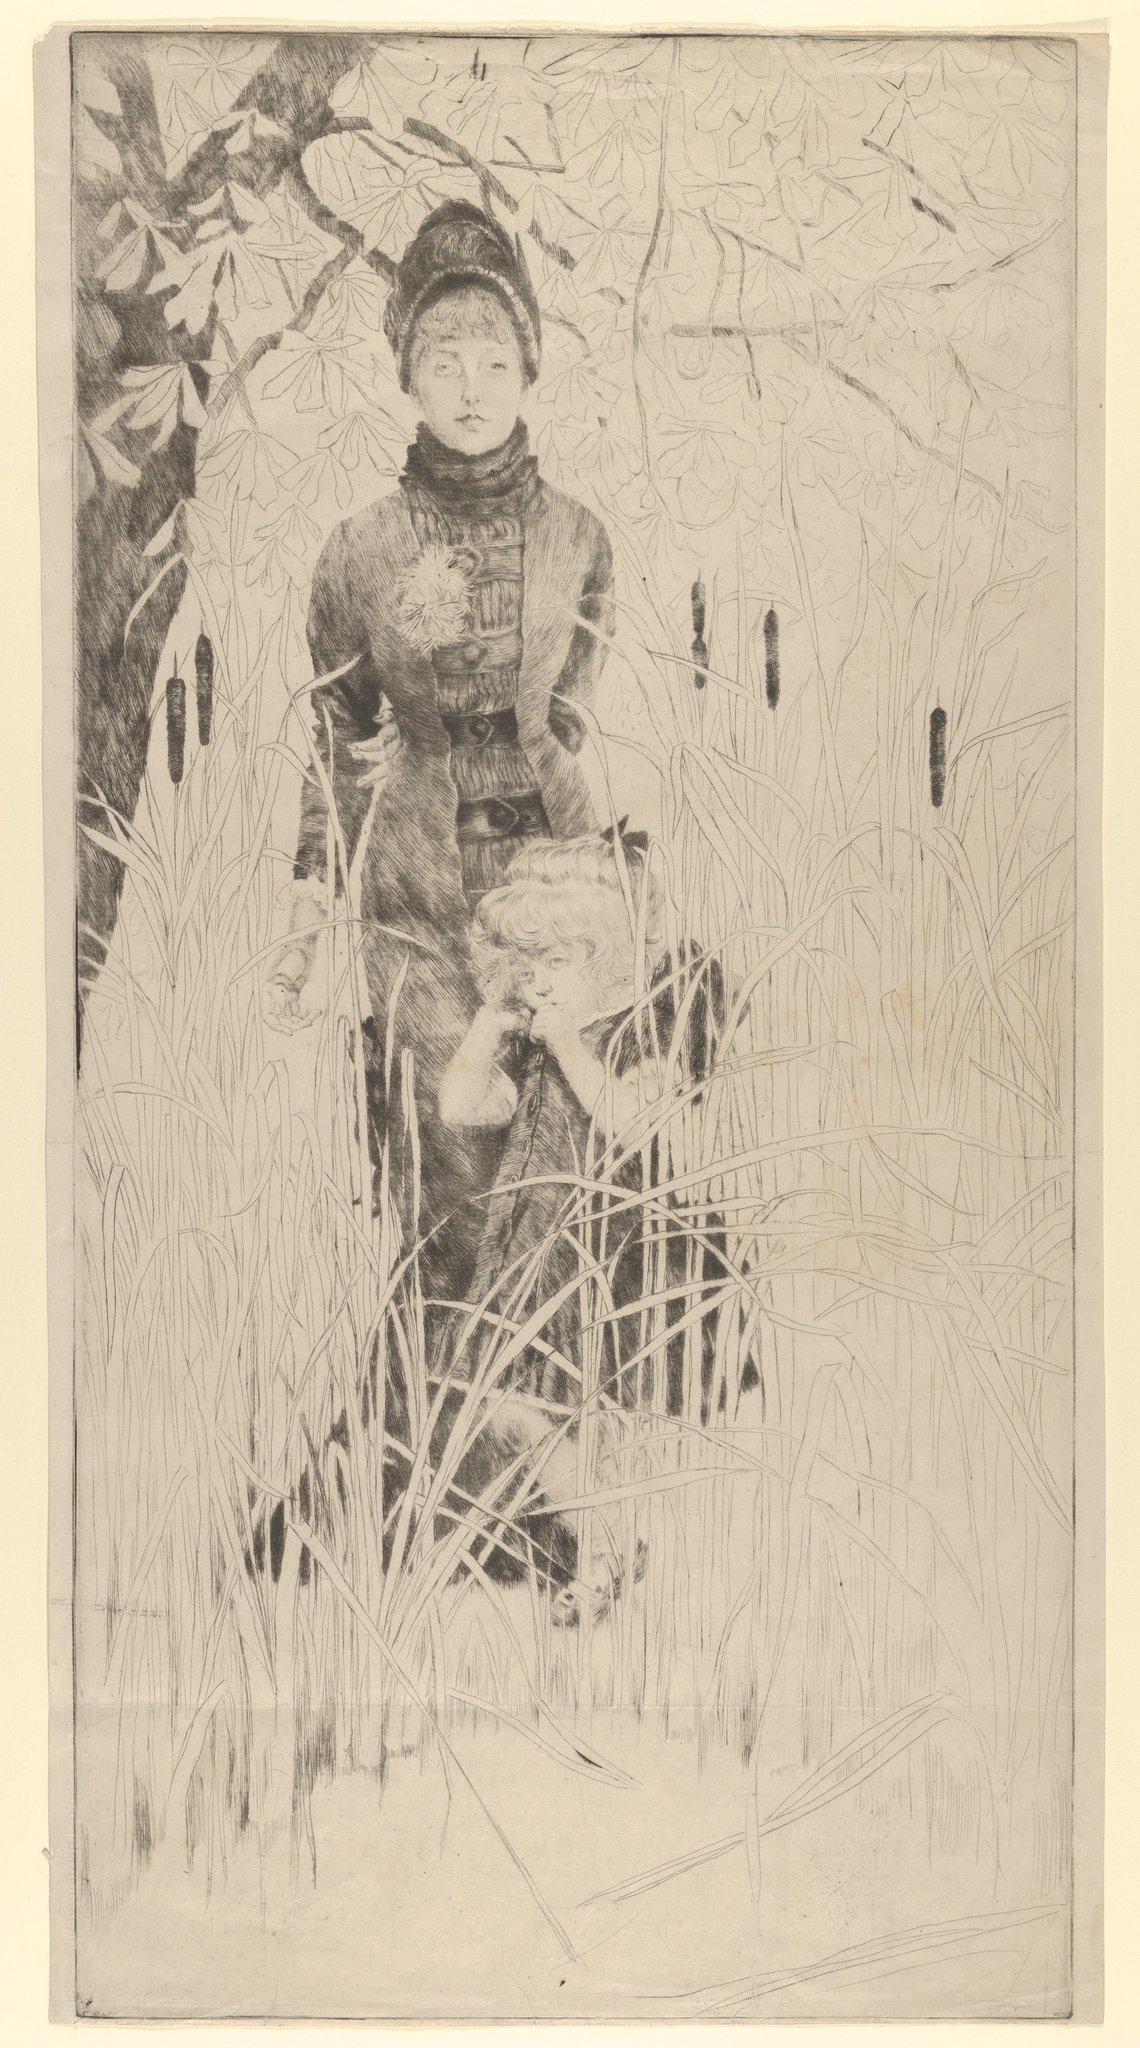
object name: print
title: Orphan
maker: james tissot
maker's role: artist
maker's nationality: french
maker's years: 1836-1902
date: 1879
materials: paper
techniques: etching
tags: girls,women